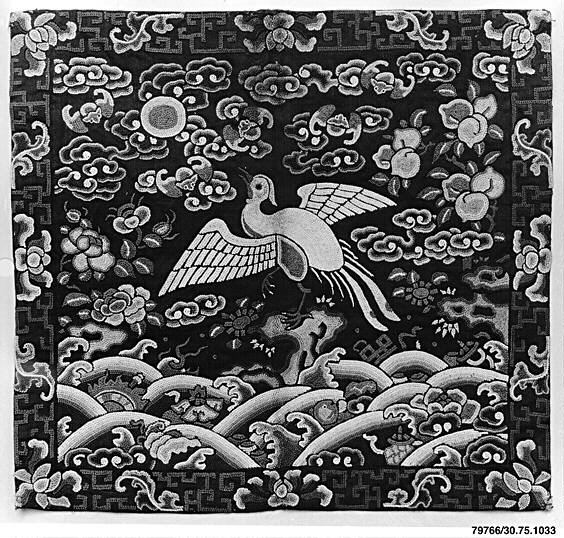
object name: rank badge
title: Rank Badge with Paradise Fly-Catcher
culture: chinese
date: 1767-1800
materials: silk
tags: bats,birds